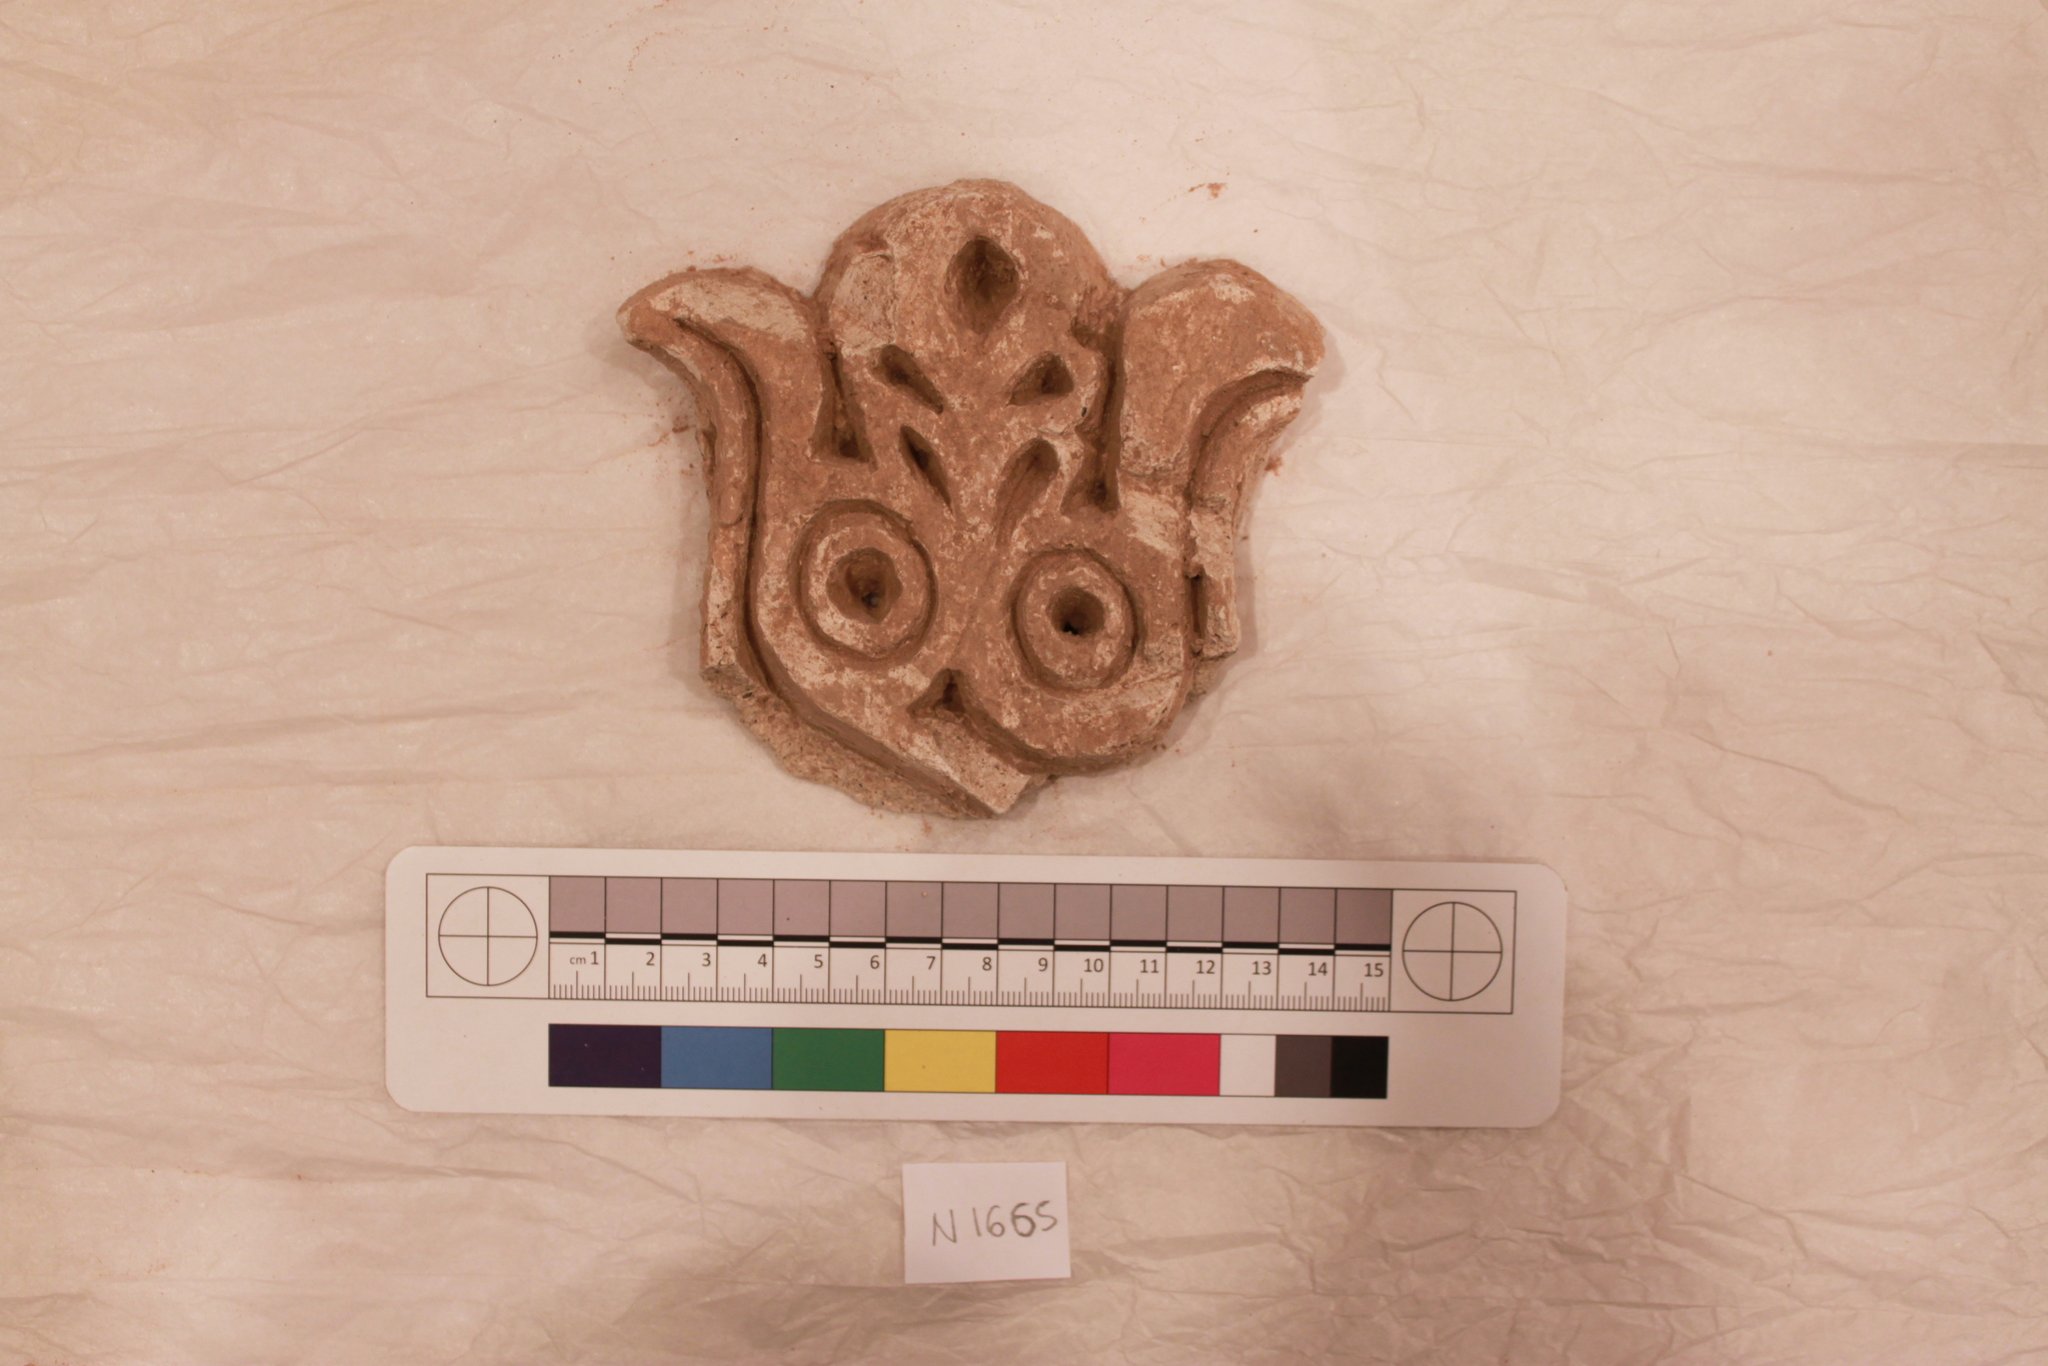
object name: fragment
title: Stucco Fragment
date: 701-1200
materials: plaster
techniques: carving, painting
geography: iran